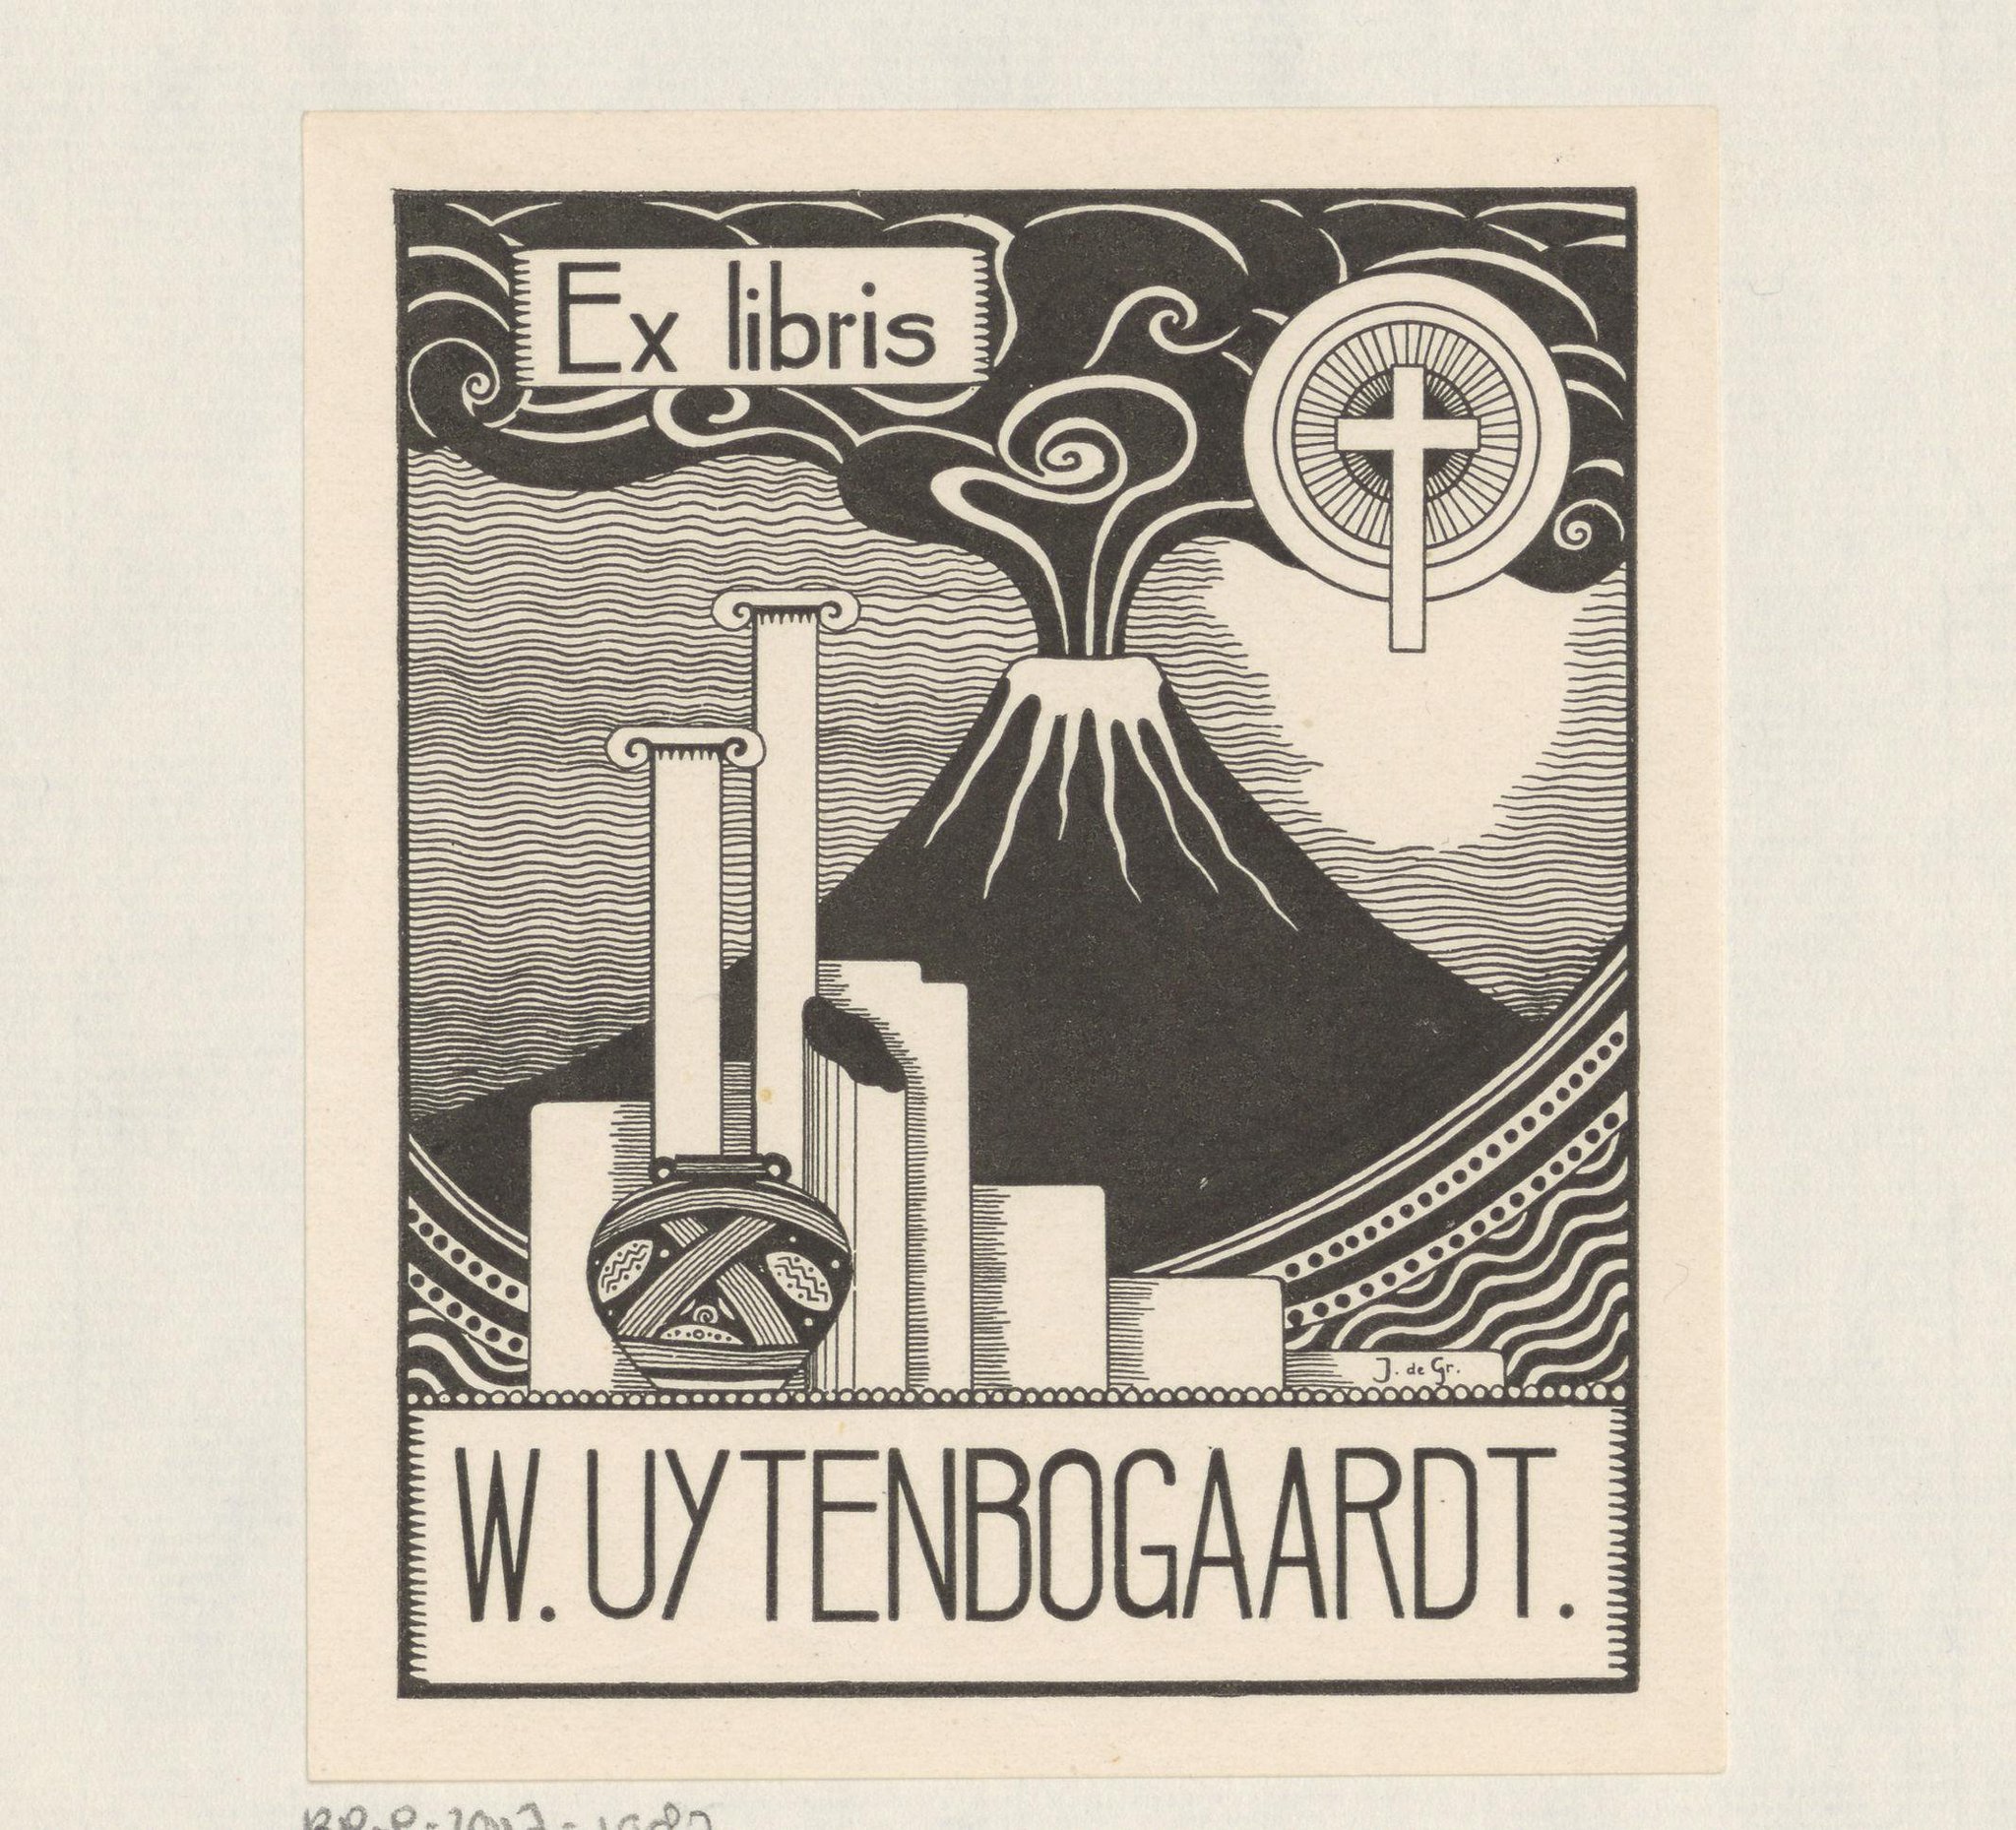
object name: bookplate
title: Ex libris van W. Uytenbogaardt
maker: Anonymous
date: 1900-1999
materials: paper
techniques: printing block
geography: netherlands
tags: column, pillar ~ architecture, christ-child (with attributes), container of ceramics: jar, jug, pot, vase, eruption (of volcano)